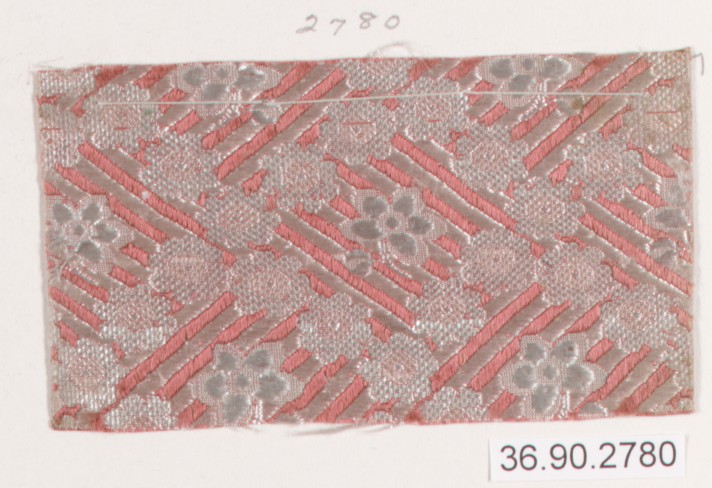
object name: piece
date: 1801-1900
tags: flowers